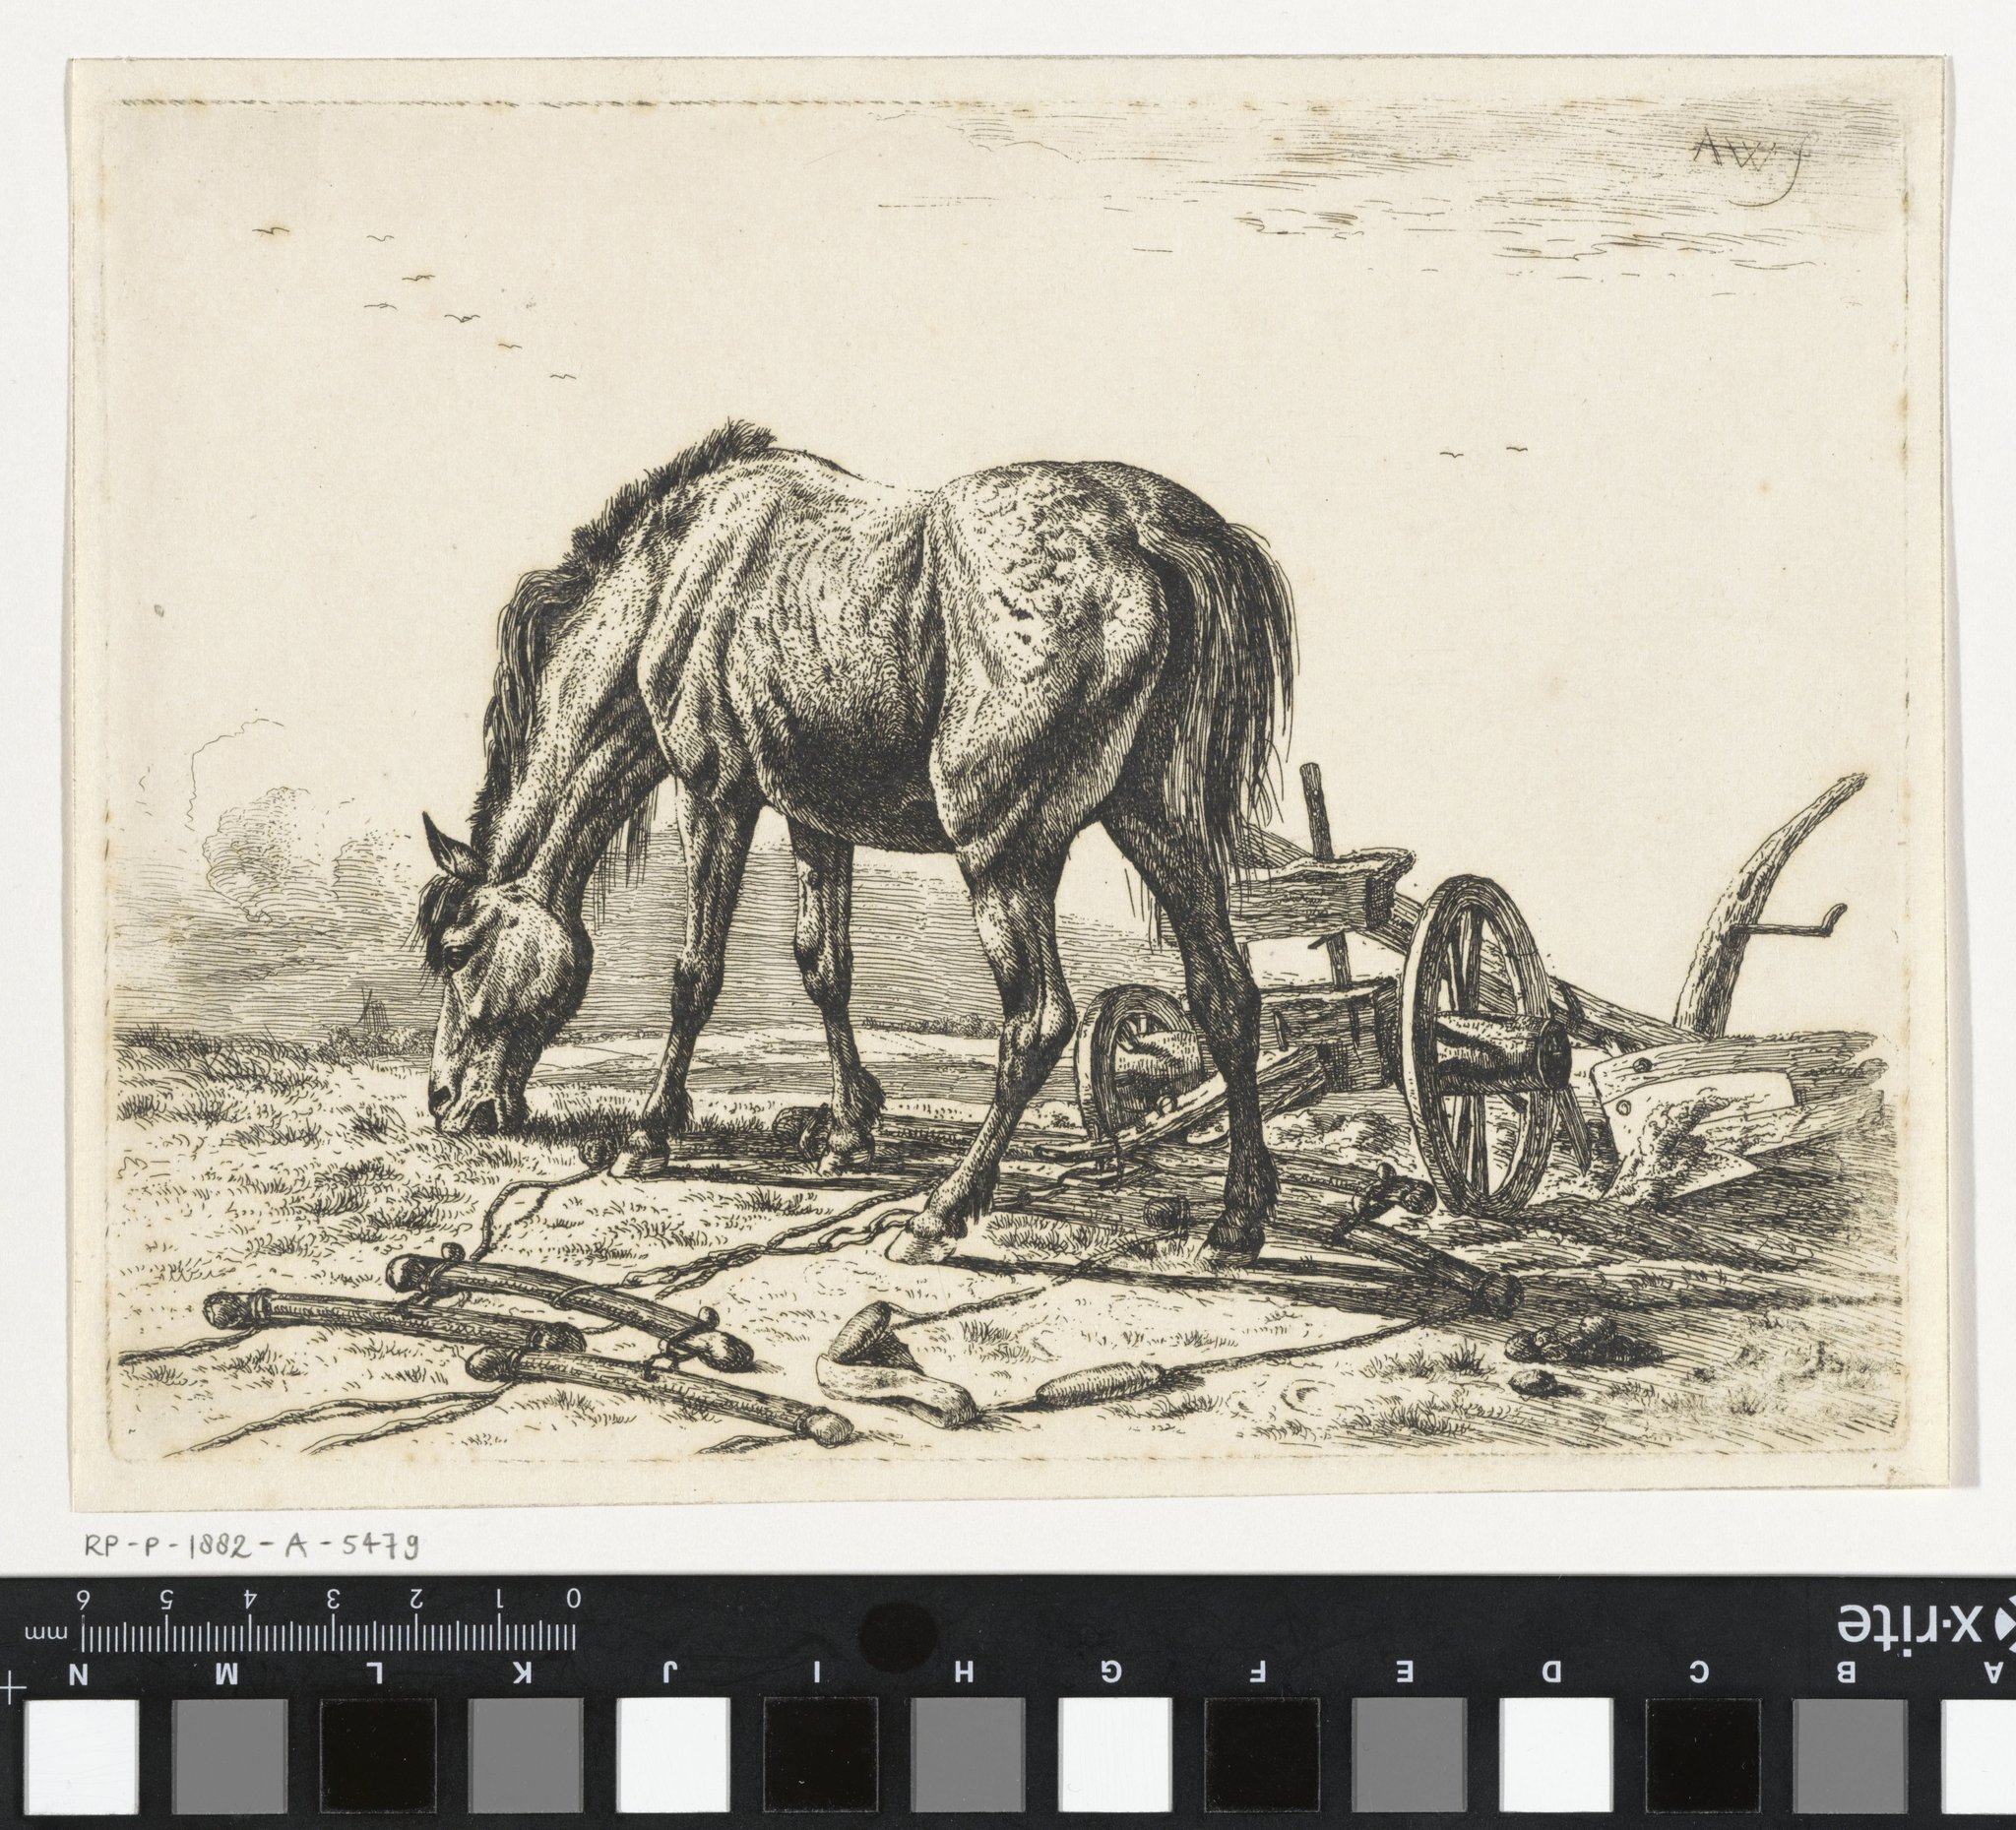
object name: print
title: Grazend paard bij een ploeg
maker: abraham hendrik winter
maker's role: painter, print maker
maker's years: 1800-1861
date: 1815-1860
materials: paper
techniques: etching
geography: utrecht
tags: horse, agricultural implements: plough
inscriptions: collector's mark: Lugt 2228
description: Een uitgespannen paard staat te grazen bij een ploeg. Rechtsvoor enkele paardenvijgen.